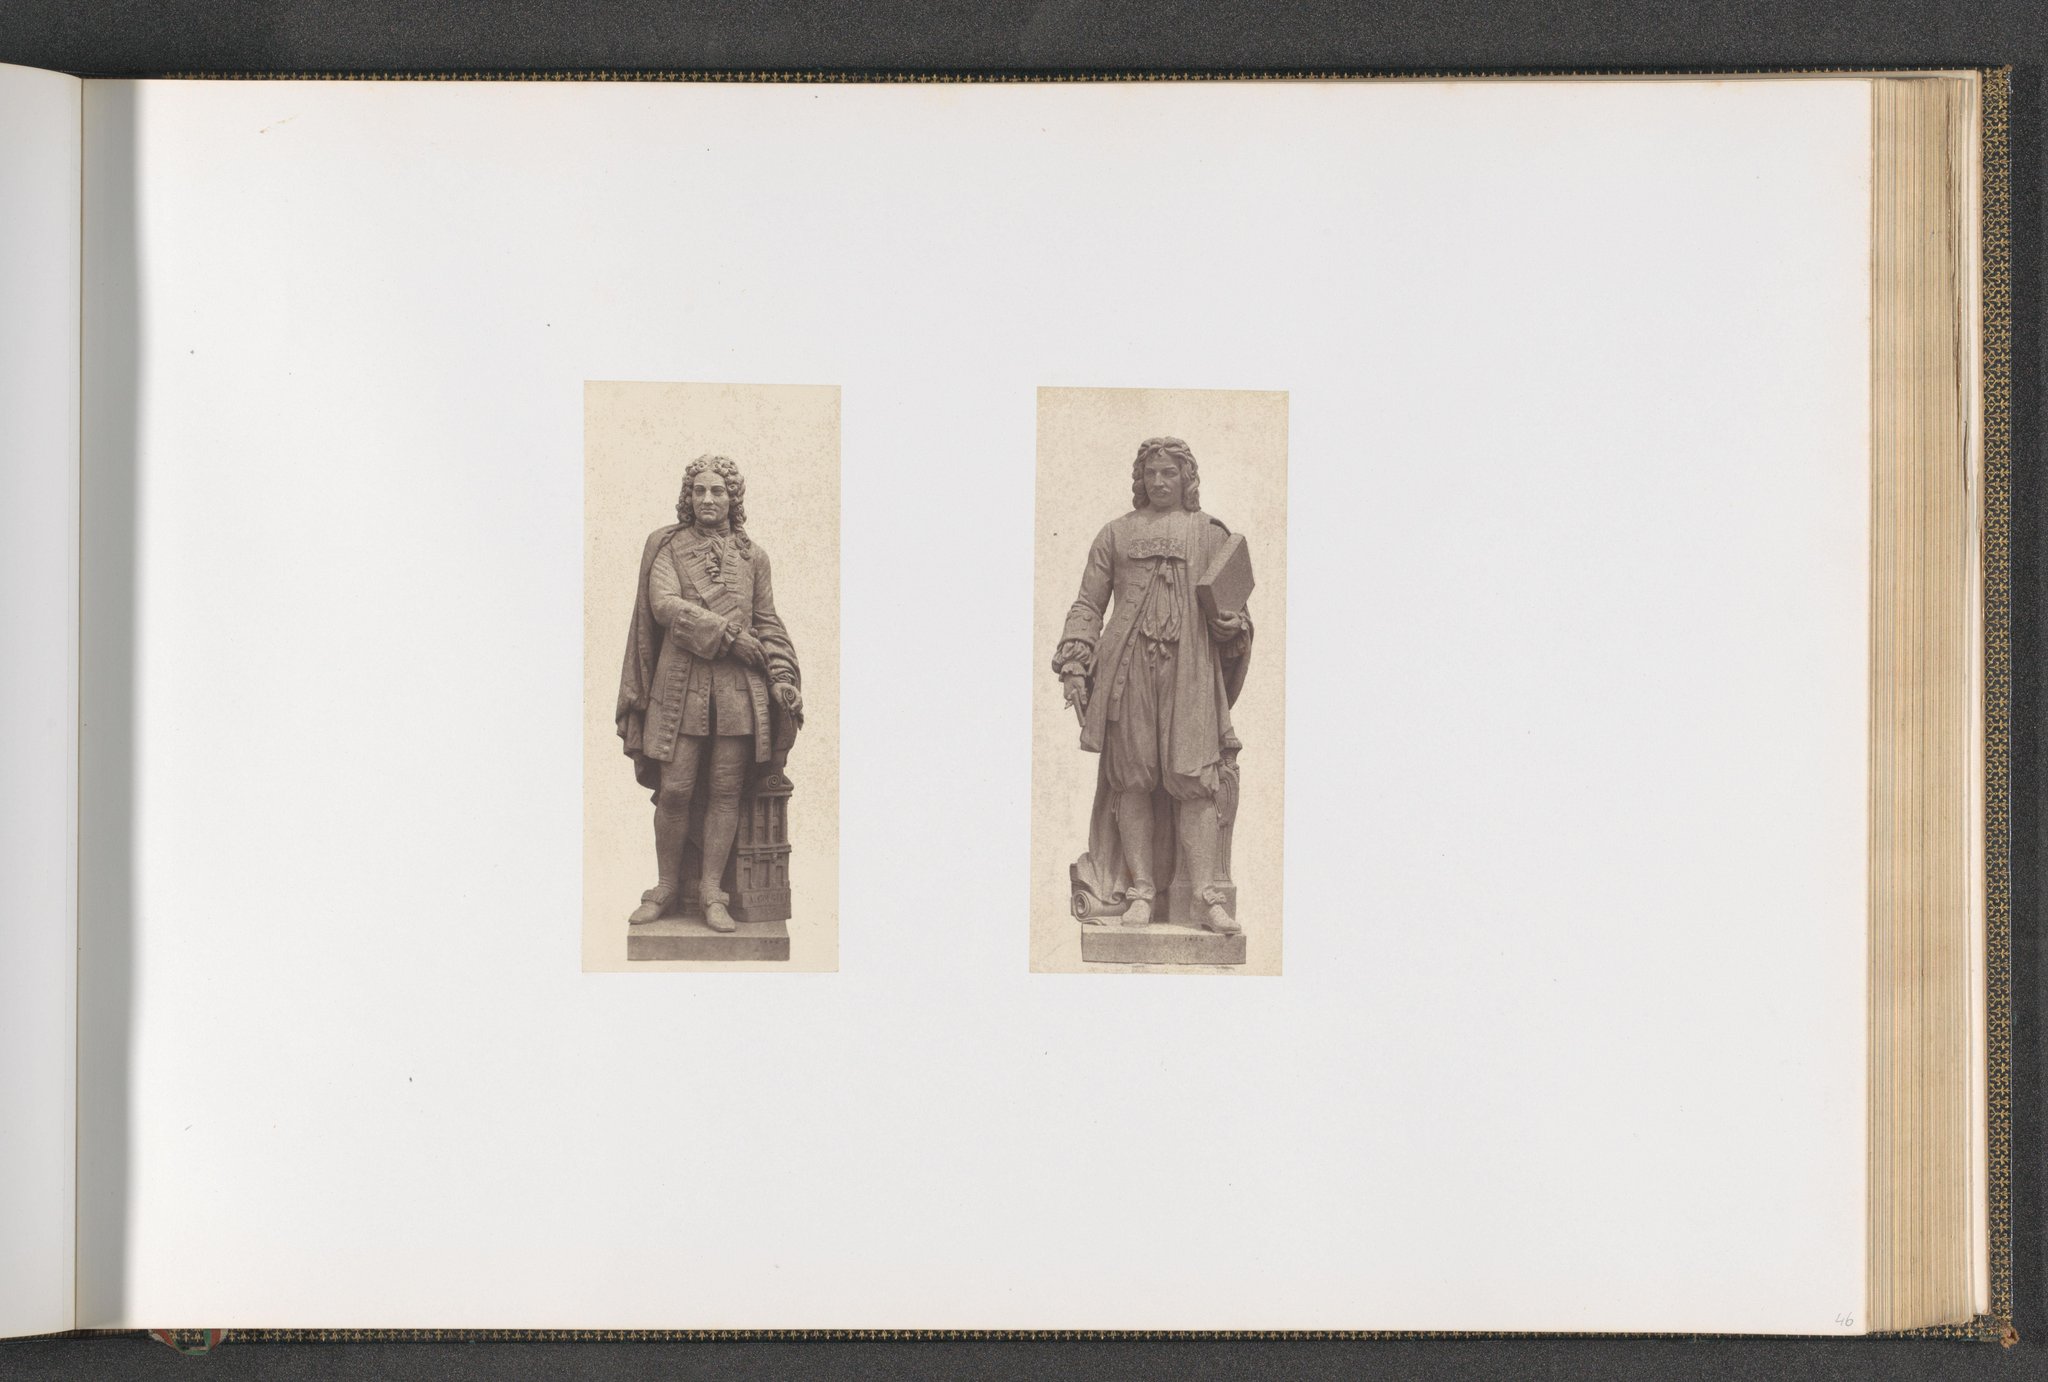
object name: photograph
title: Gipsmodellen voor beeldhouwwerken op het Palais du Louvre: links "Gabriel" door Augustin Courtet en rechts "Lepautre" door Astyanax Bosio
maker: édouard denis baldus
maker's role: fotograaf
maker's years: 1813-1889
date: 1855-1857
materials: paper, photographic support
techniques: salted paper print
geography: paris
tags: piece of sculpture, reproduction of a piece of sculpture, permanent exhibition, museum, paris, tuileries palace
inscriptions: number: ‘[...] en 1038’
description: Onderdeel van Réunion des Tuileries au Louvre 1852-1857, album 2.